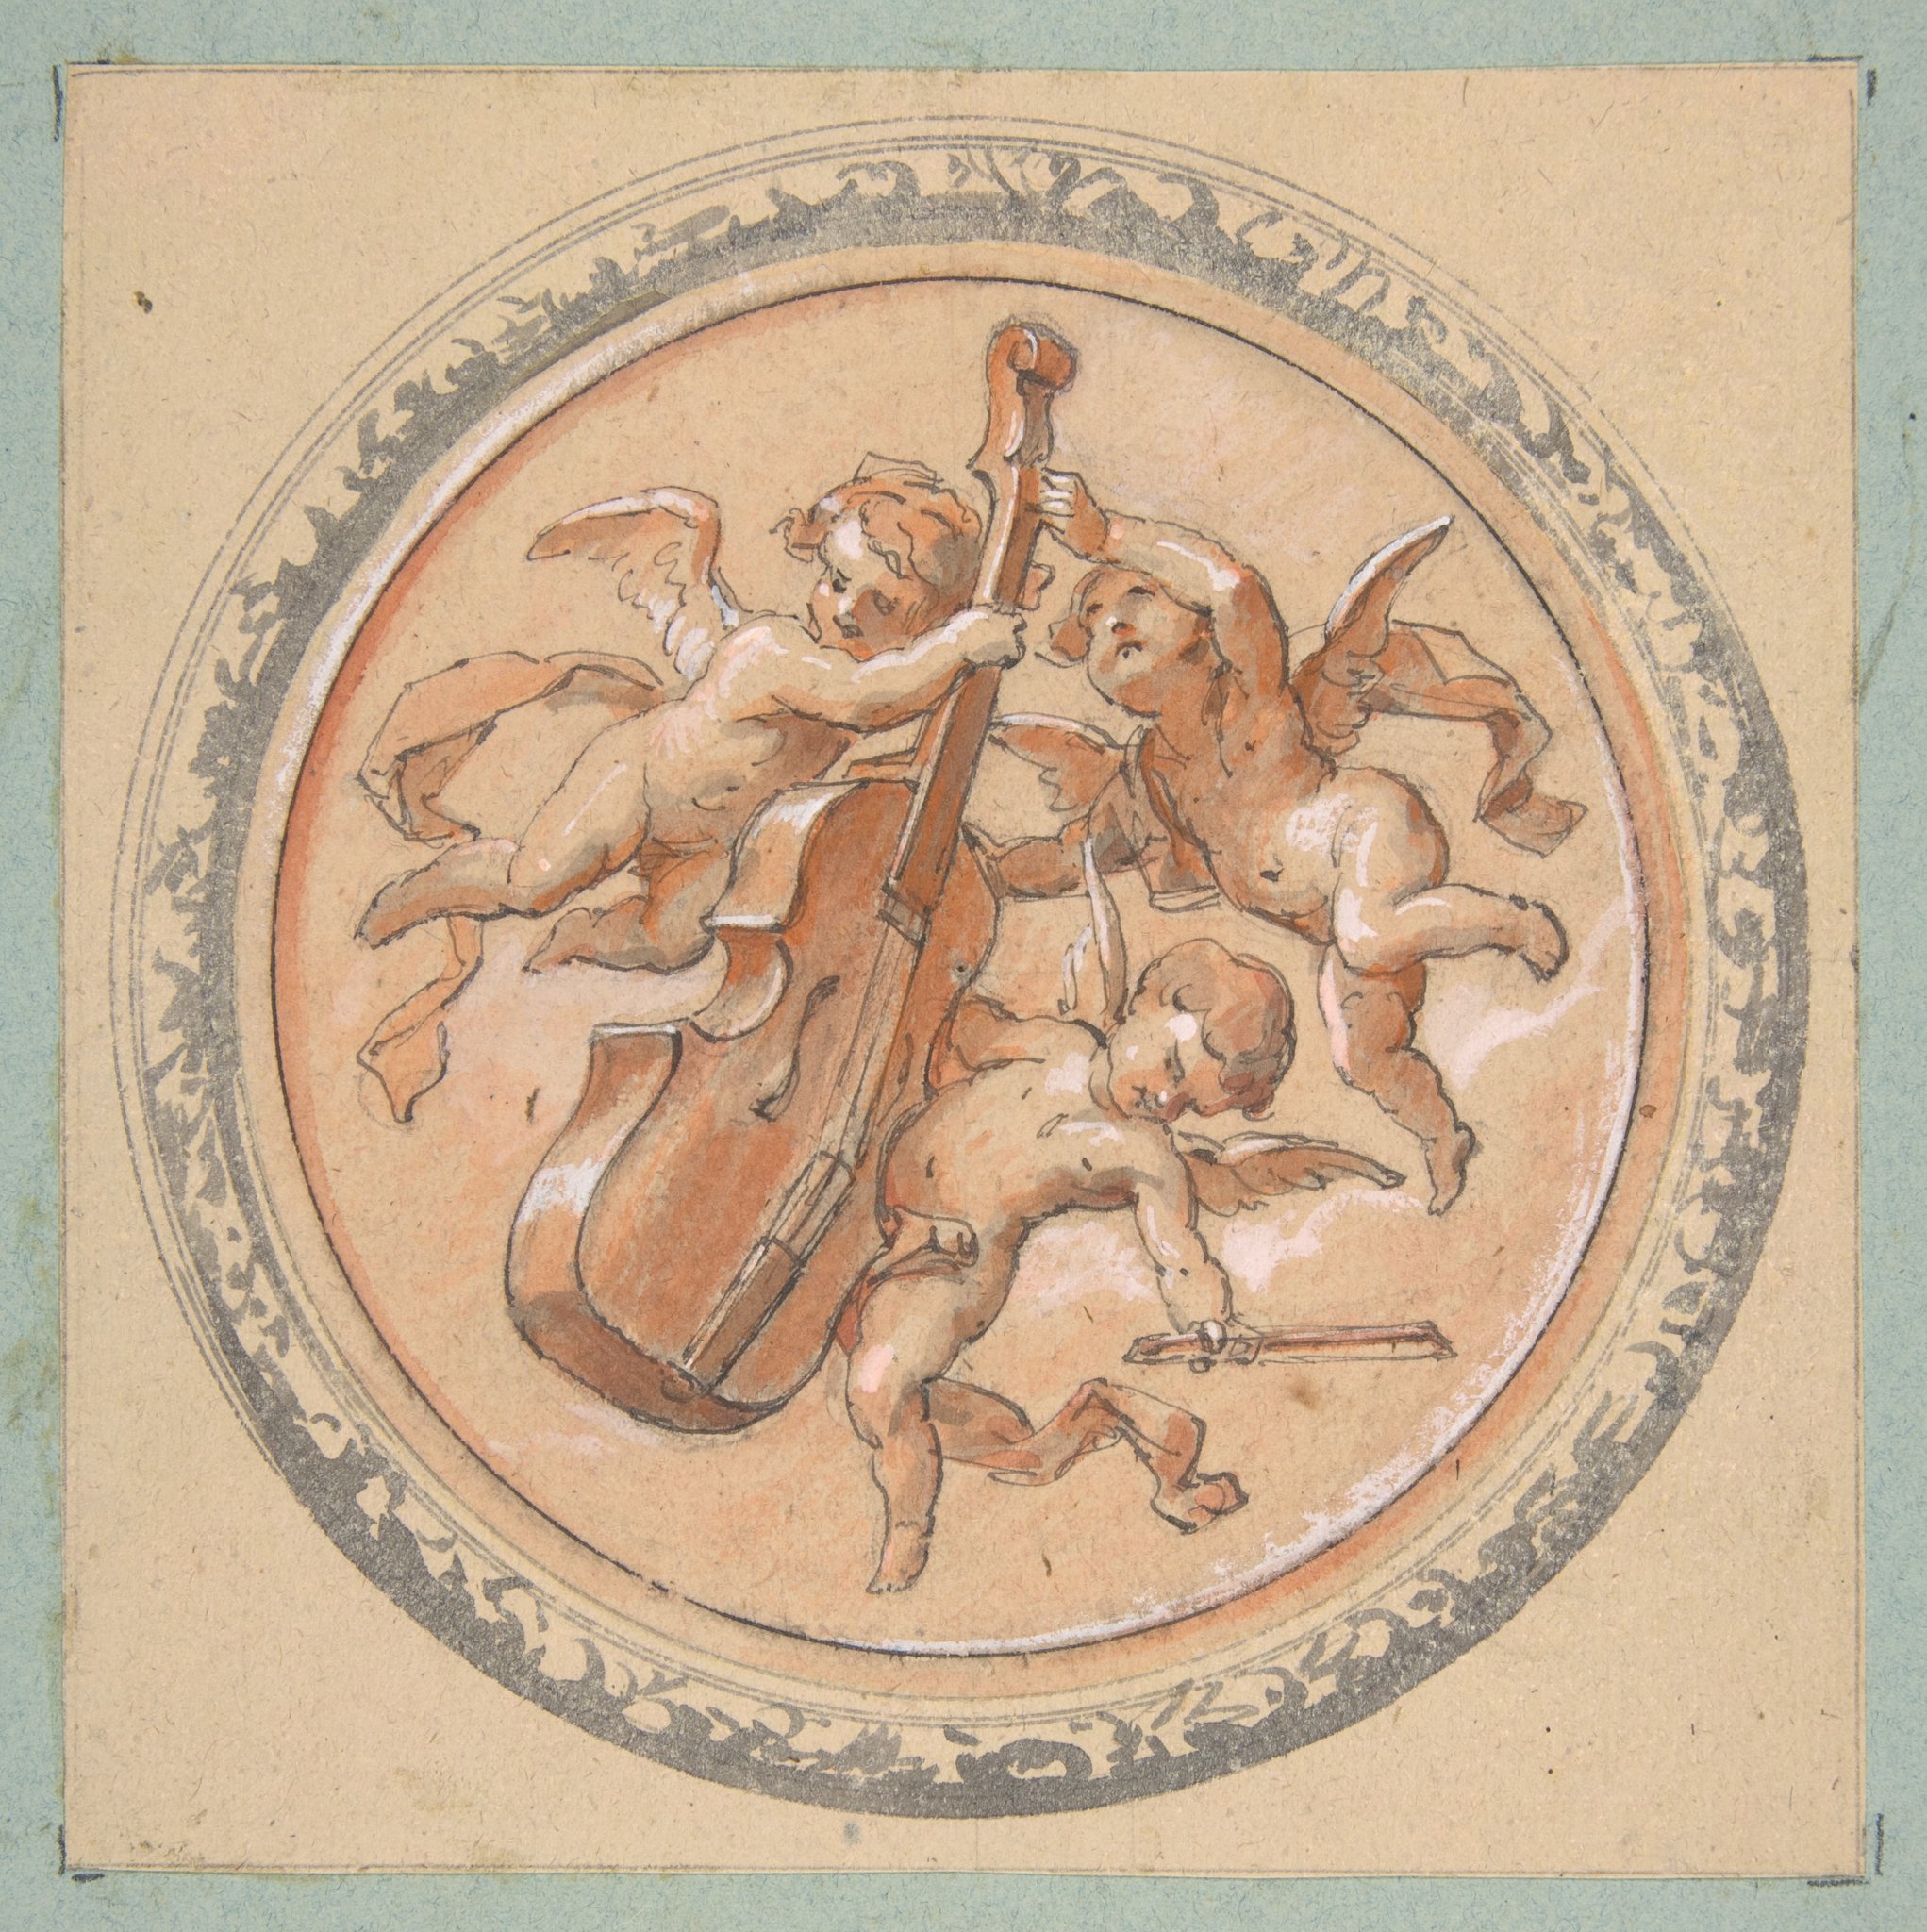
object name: drawing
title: Medallion with putti holding a cello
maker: jules-edmond-charles lachaise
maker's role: artist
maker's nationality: french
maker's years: 1897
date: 1851-1900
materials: graphite, watercolor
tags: cellos,putti